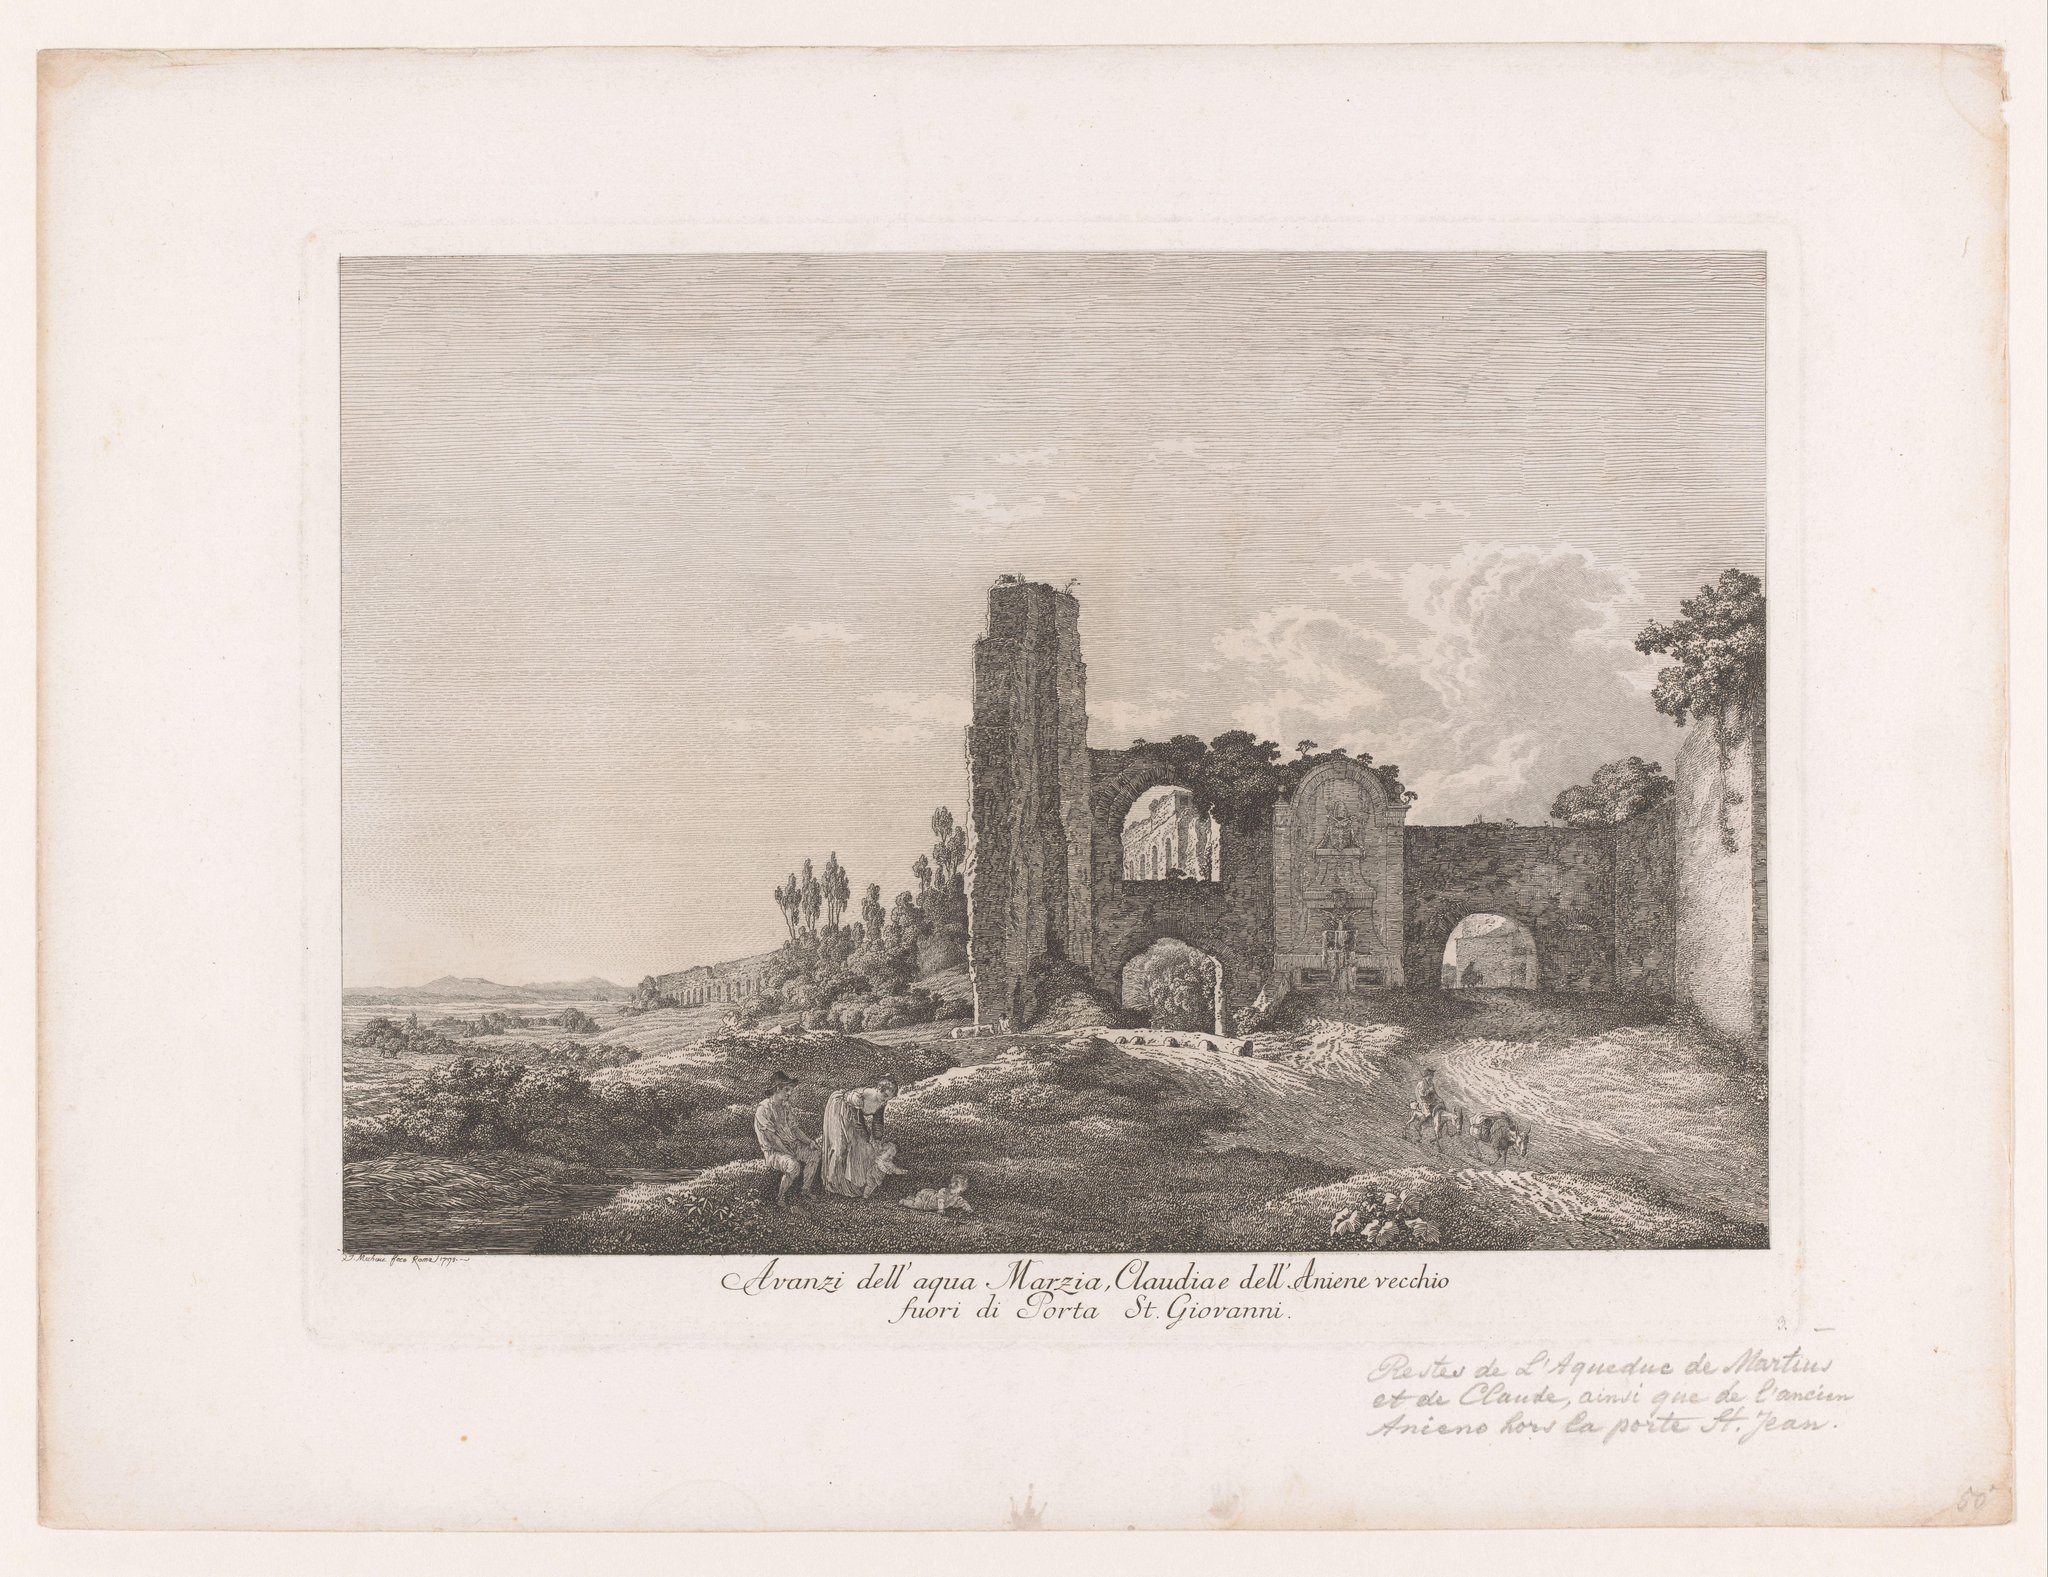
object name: print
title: Avanzi dell' aqua Marzia (...) Porta St. Giovanni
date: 1793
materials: paper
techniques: etching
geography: rome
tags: landscape with ruins (+ city(-scape) with figures, staffage)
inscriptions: collector's mark: Lugt 2228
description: Behorend tot een set van 72 'Mahlerisch-radirte Prospecte von Italien', waarvoor de kunstenaar 24 prenten maakte. Albert Christoph Dies (1755-1822) en Johann Christian Reinhart (1761-1847) maakten eveneens 24 platen, in opdracht van Jean Fréderic Frauenholz.